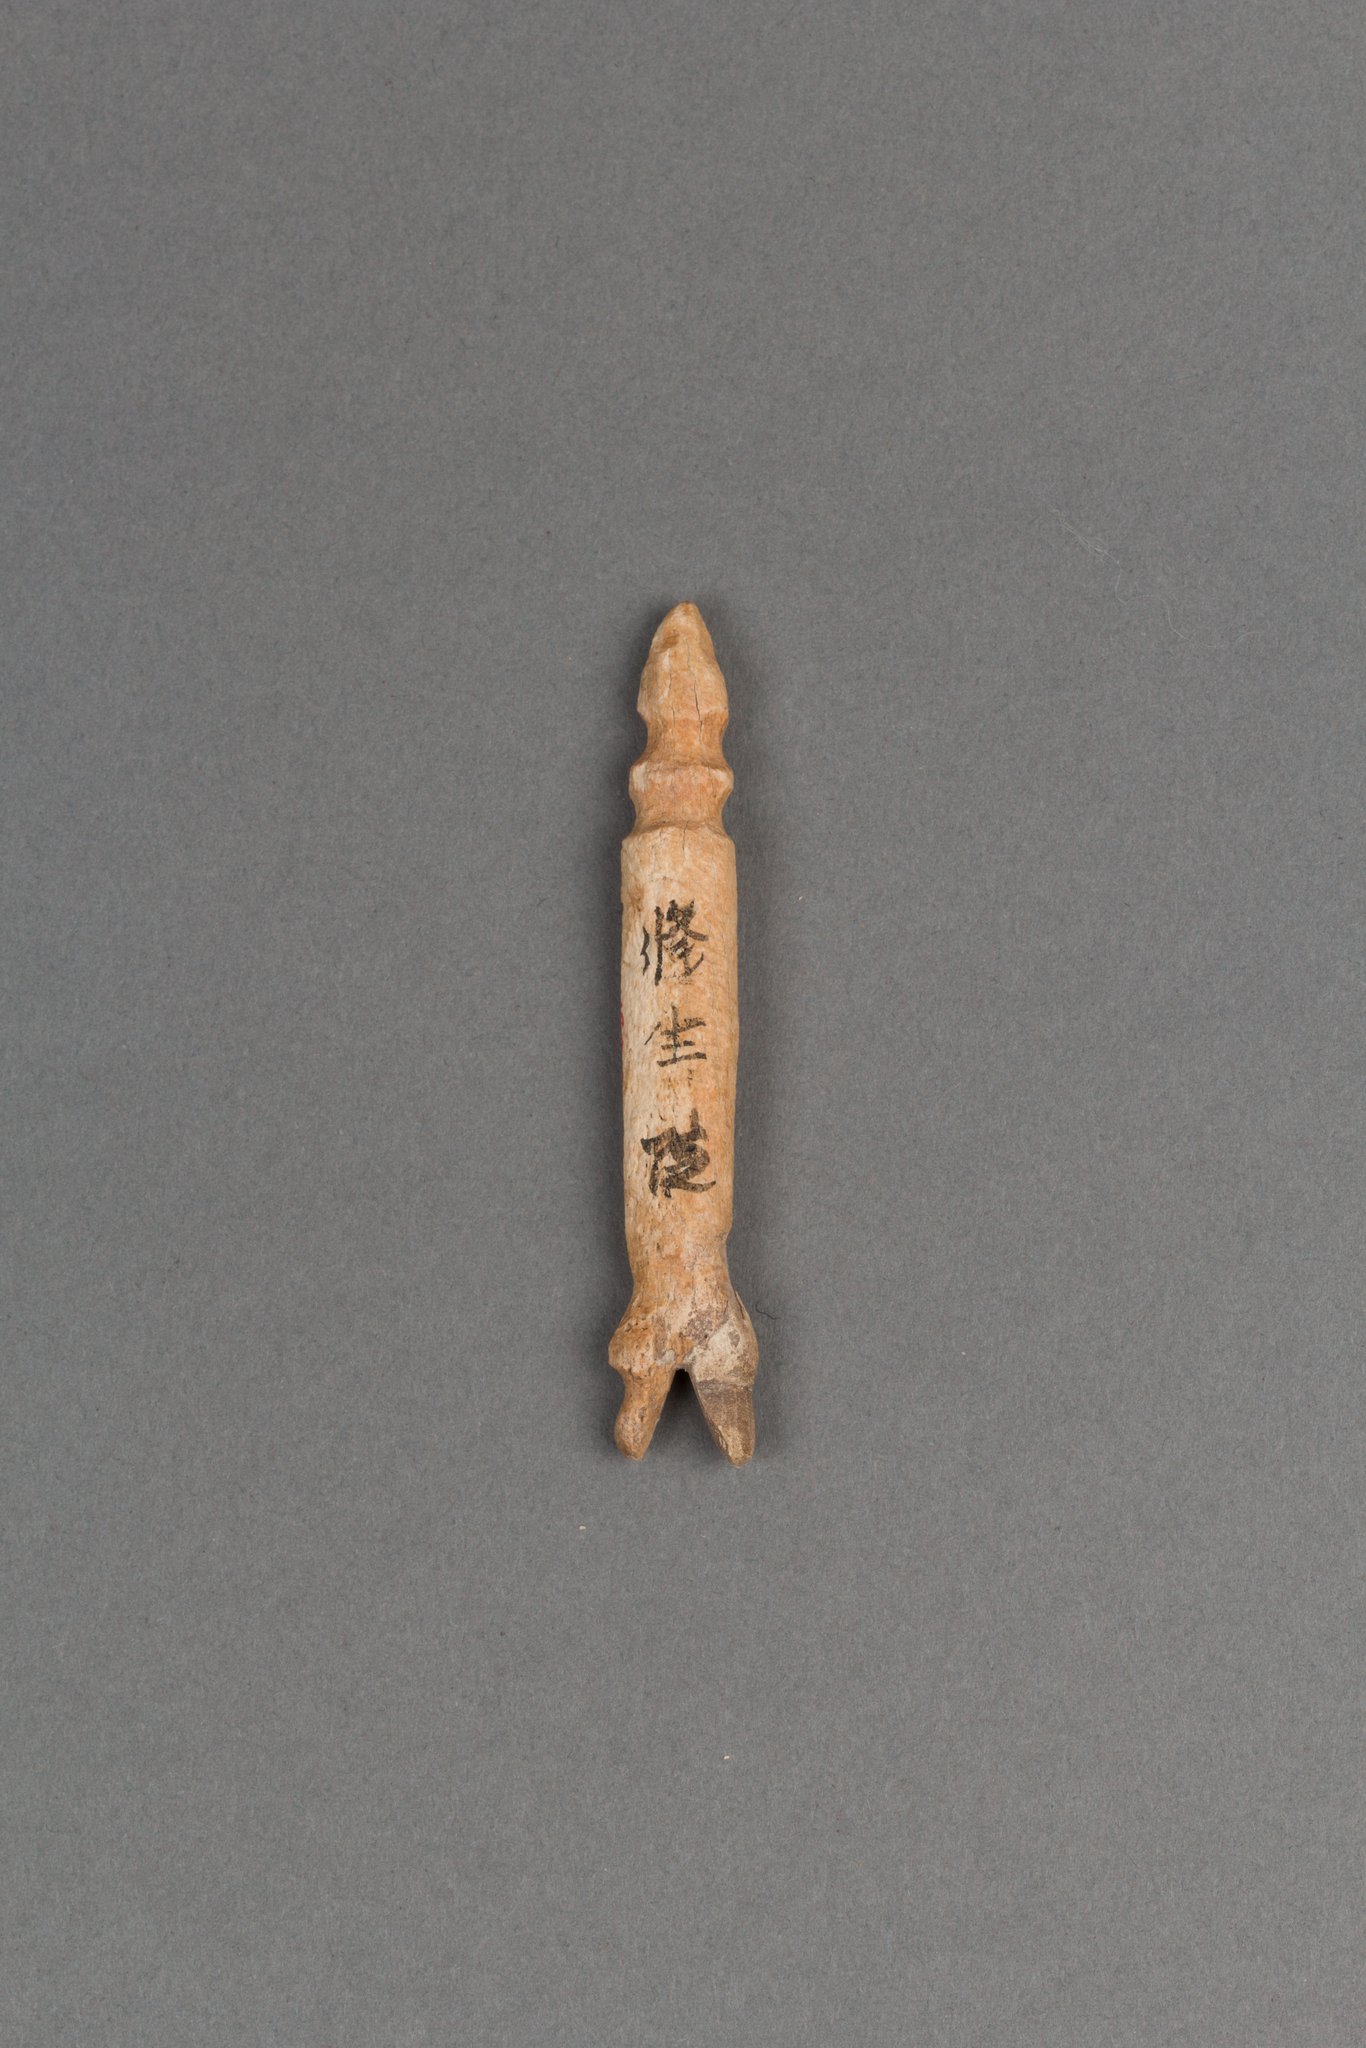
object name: body ornament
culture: japanese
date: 1200-200 BCE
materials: bone